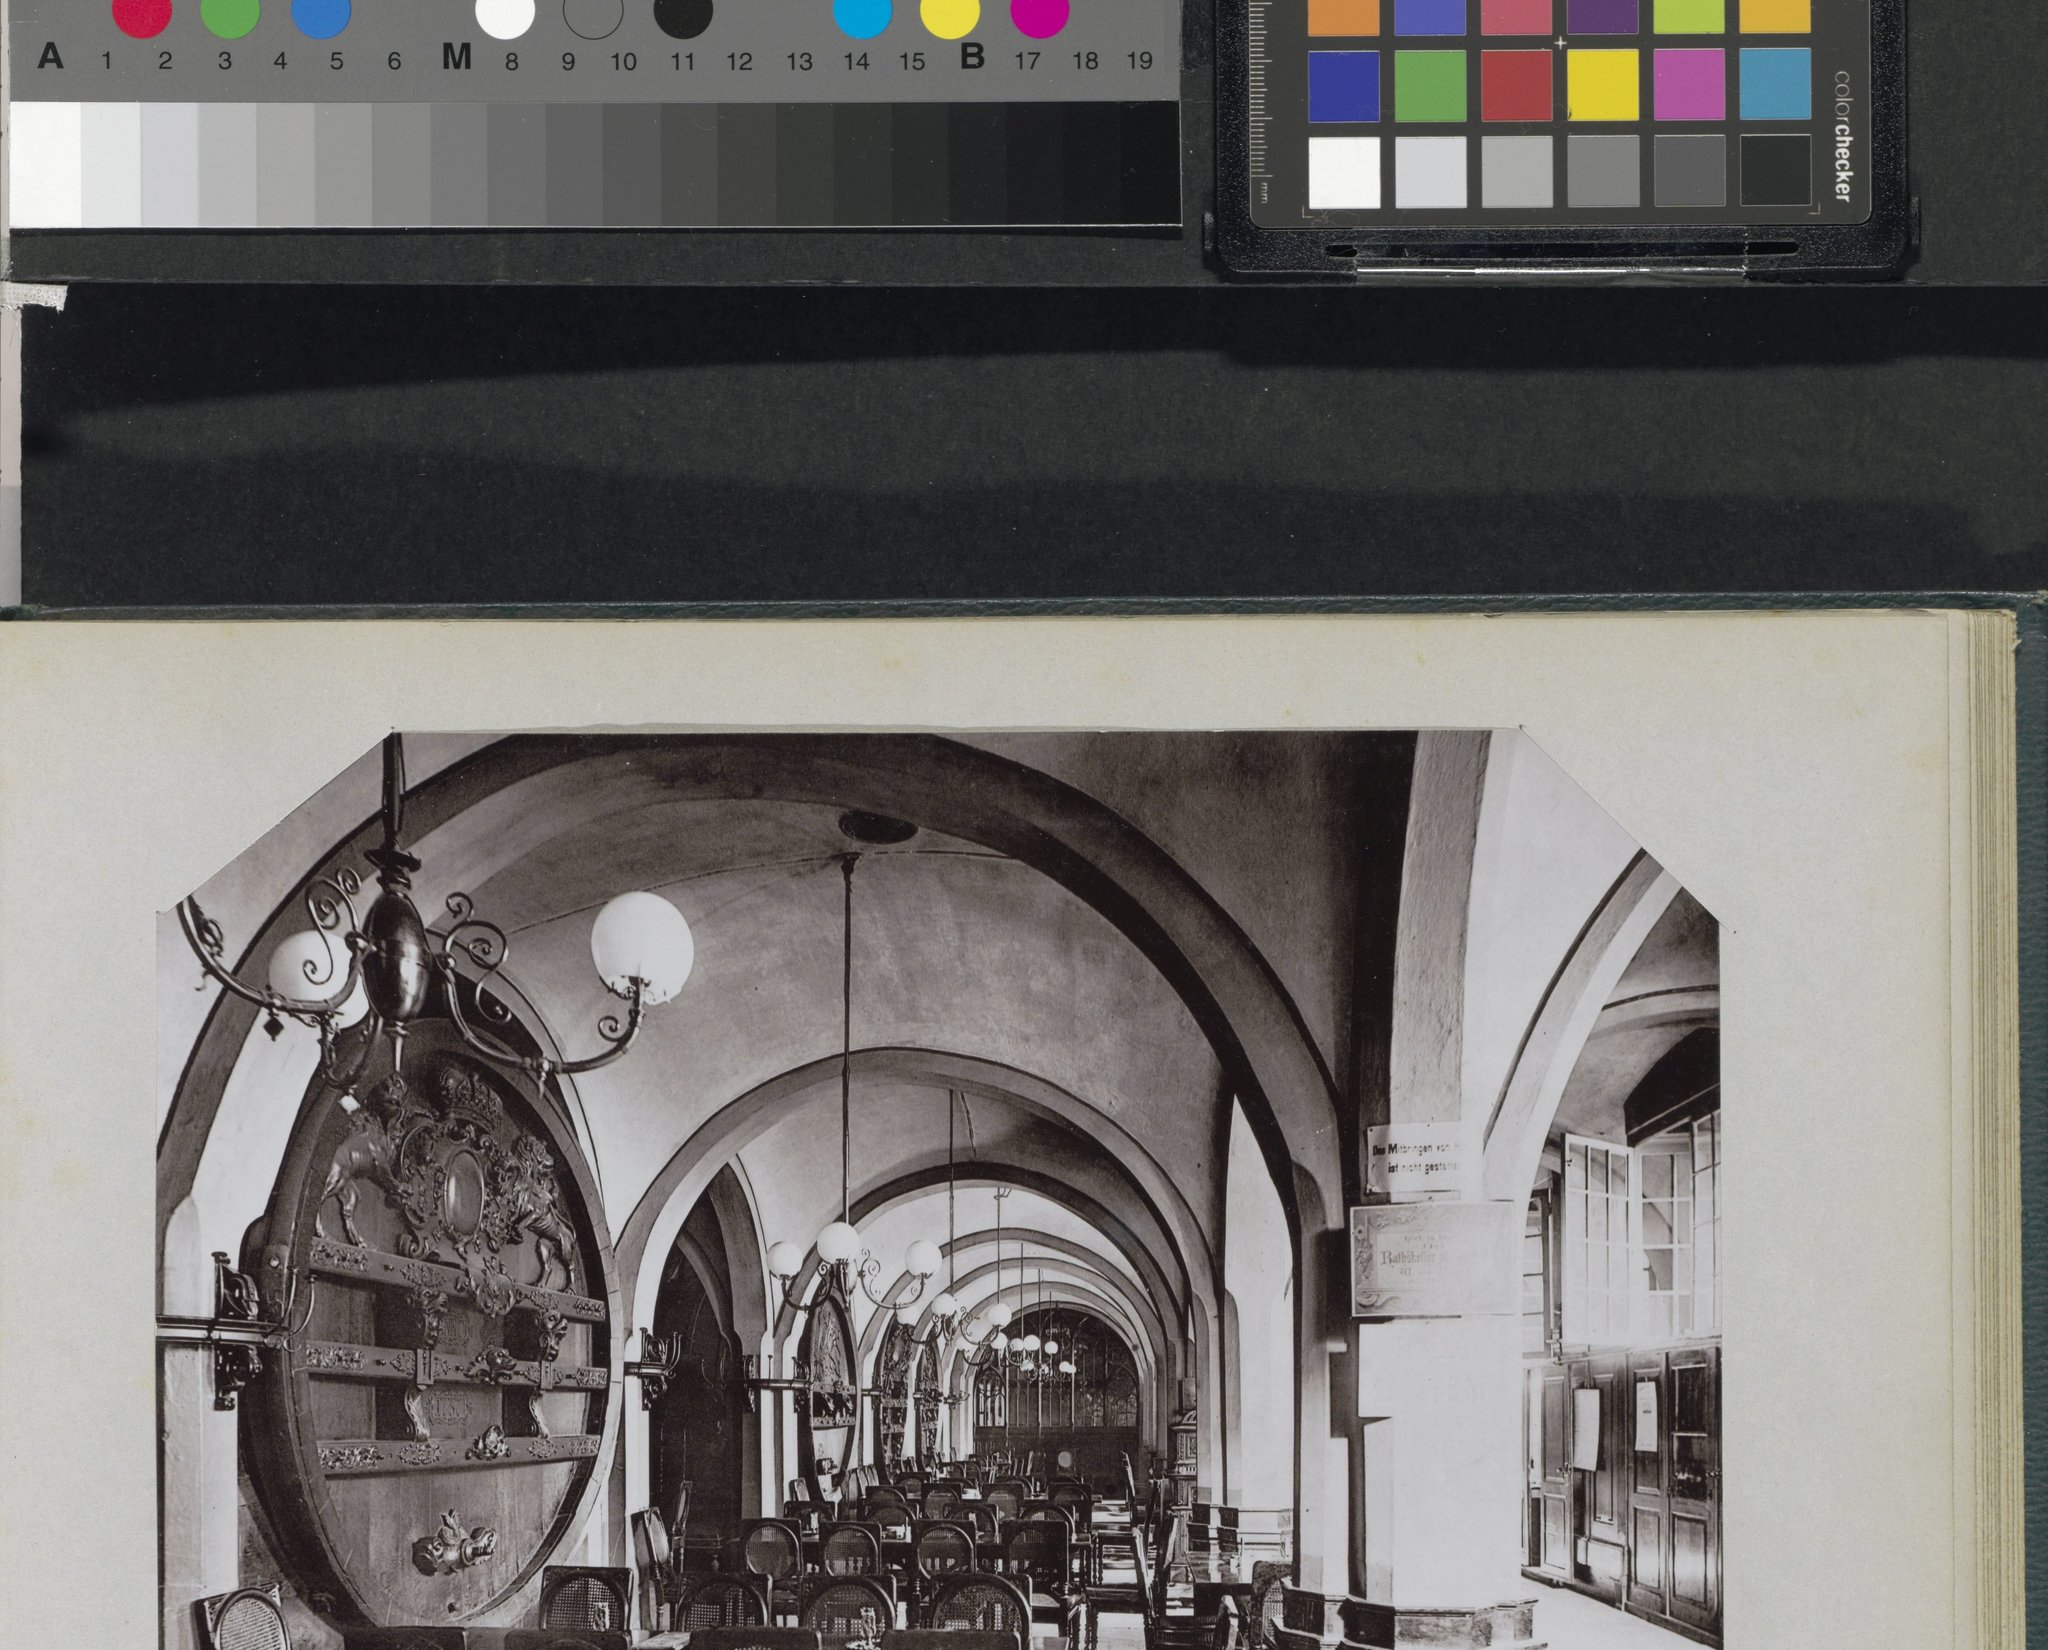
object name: album leaf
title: Raadskelder in Bremen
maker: Anonymous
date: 1895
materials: paper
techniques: photograph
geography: darmstadt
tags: wine-cellar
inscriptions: inscription: ‘Bremen, Rathskeller/ Verlag v. Zedler u. Vogel Darmstadt 1895’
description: Deze prent maakt deel uit van een album.